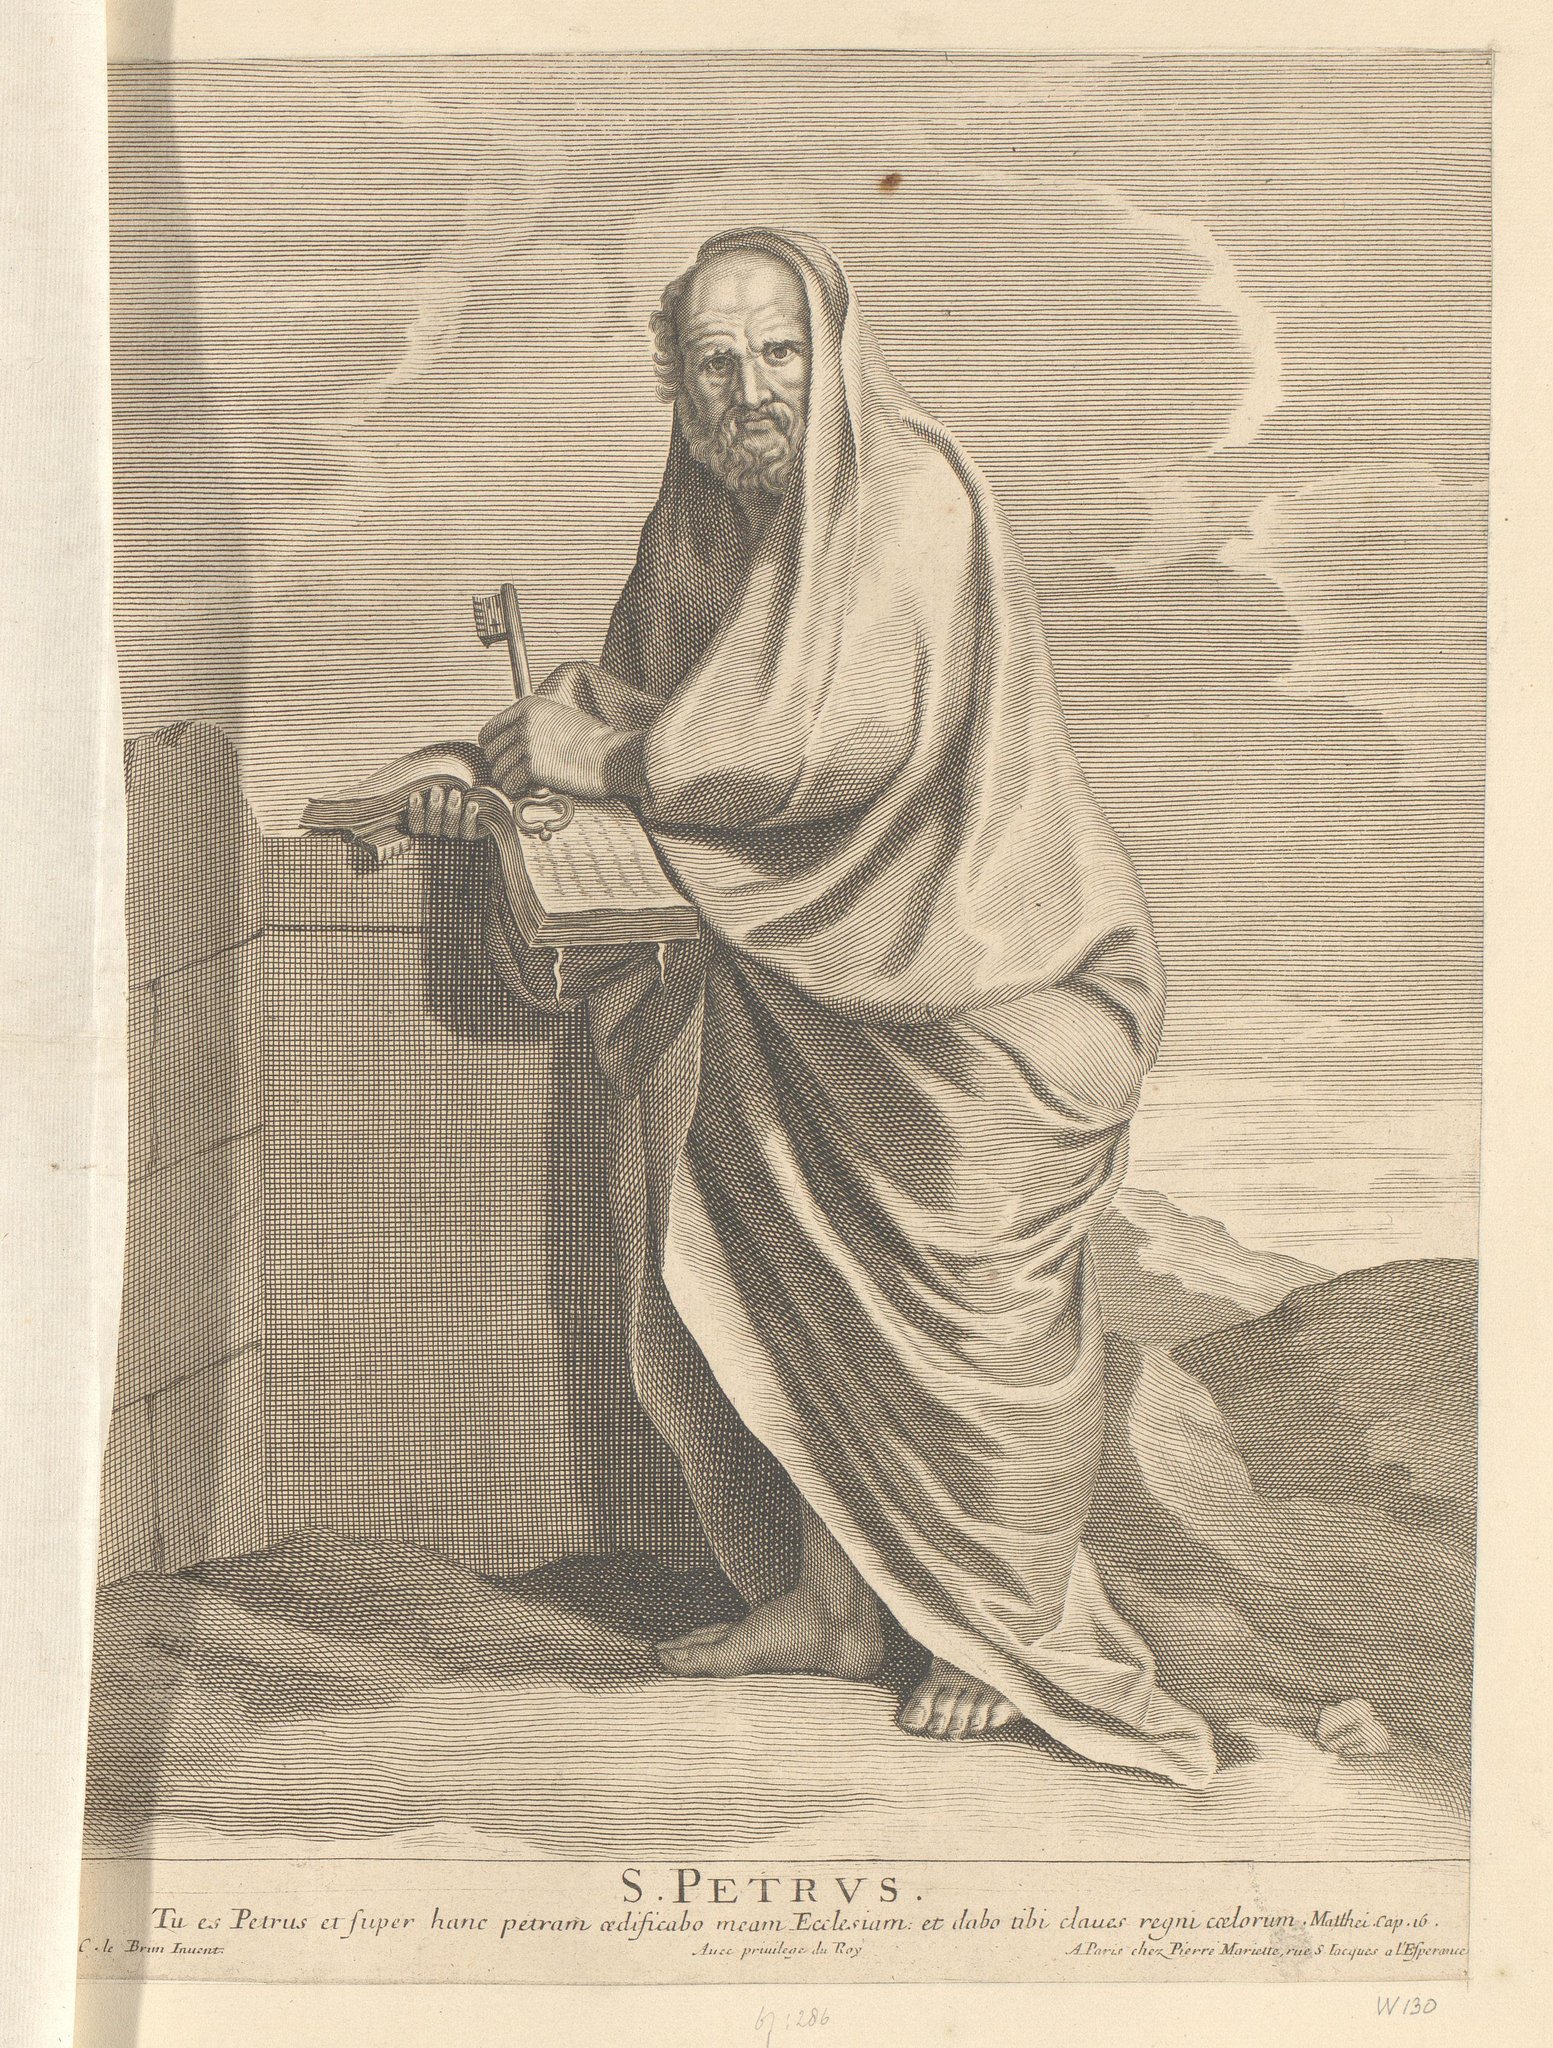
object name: print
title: Apôtres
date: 1650-1700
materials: paper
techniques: engraving, etching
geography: paris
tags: the apostle peter, first bishop of rome; possible attributes: book, cock, (upturned) cross, (triple) crozier, fish, key, scroll, ship, tiara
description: Deze prent maakt deel uit van een album.